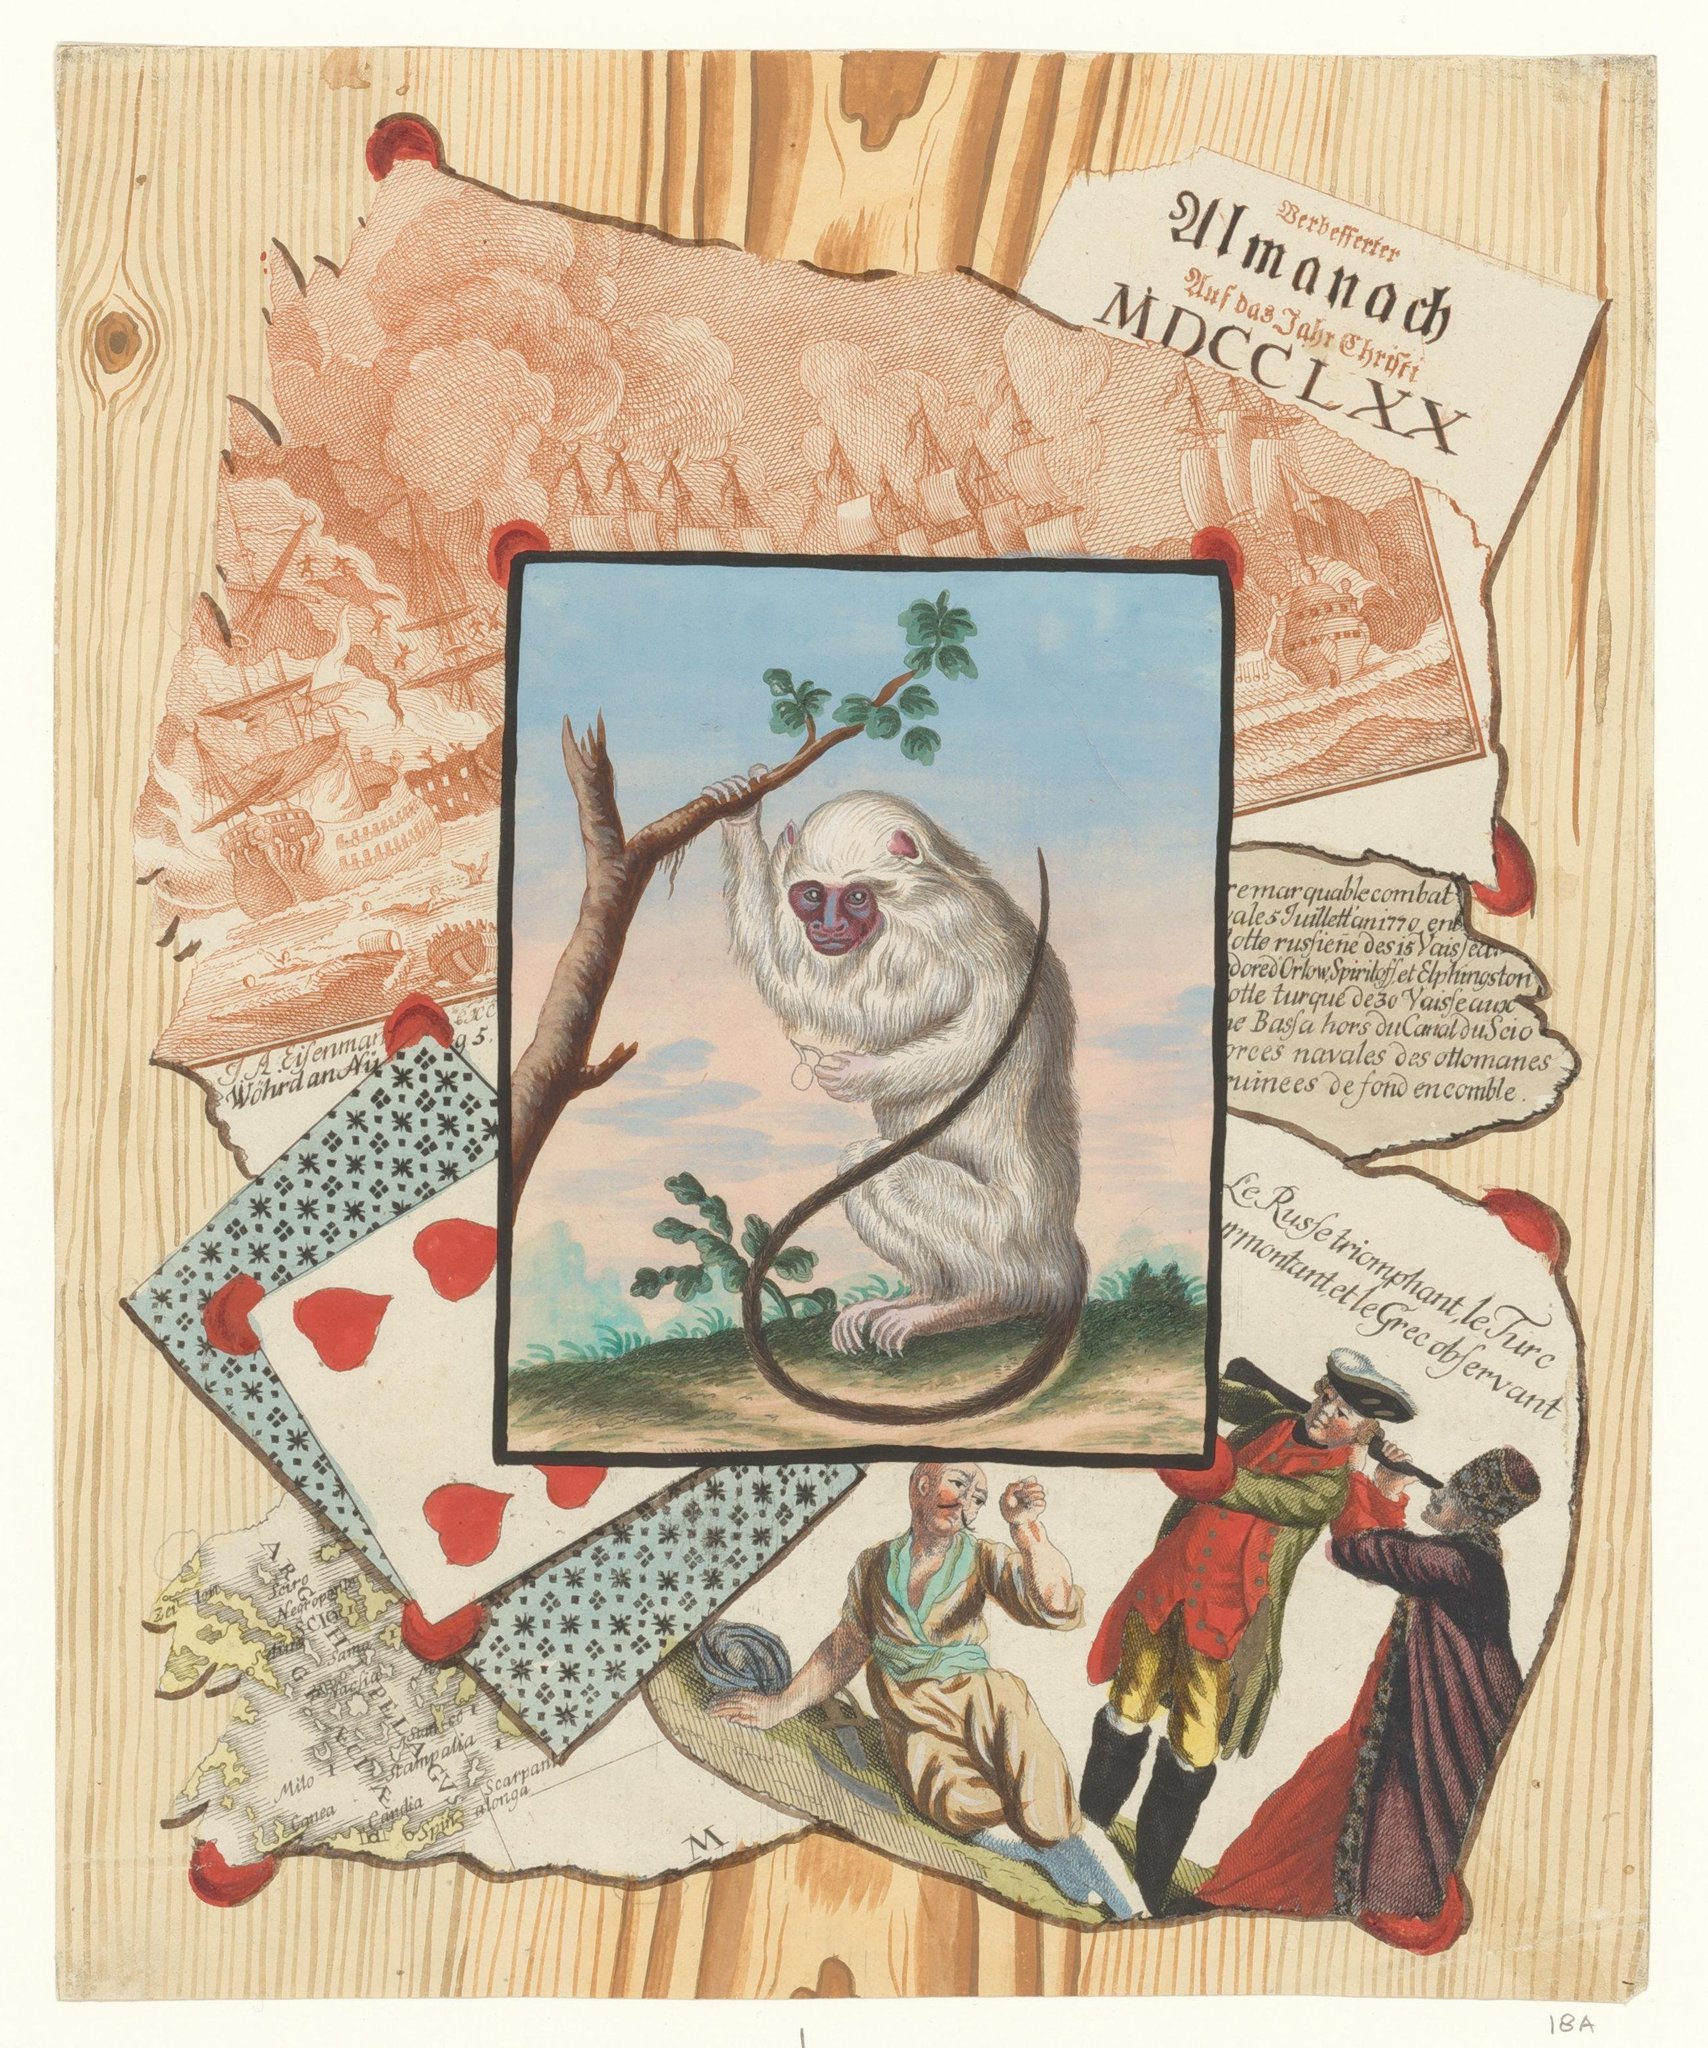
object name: drawing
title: Schijnbedrieger met tekening van een zilver-oeistiti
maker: Anonymous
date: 1750-1849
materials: ink, paint, paper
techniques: brush, pen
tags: 'trompe l'oeil', drawing, sketch, maps of separate countries or regions, monkeys, apes, single printed leaf: broadsheet, leaflet, printed matter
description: Boerenbedrieger of trompe-l'oeil bestaande uit acht bladen of fragmenten van bladen. De achtergrond is een plank met nerven en knoesten. Schijnbedrieger met in het middel een tekening van een zilver-oeistiti. Verder speelkaarten een prent van een zeeslag, een landkaart van de Griekse Eilanden. titelblad van de 'Verbesserter Almanach auf das Jahr Christi MDCCLXX', een tekst in het Frans over de zeeslag op 5 juli 1770 waarbij Turkije door Rusland werd verslagen in de Griekse wateren. Rechts onder een prent met opschrift 'Le Russe triomfant, le Turc (...) montant et le Grec observant'. De bladen zijn met zegellak bevestigd. Onderwerpsrubrieken binnen de Atlas Zeden en Gewoonten: Schoone kunsten, Schijnbedriegers.